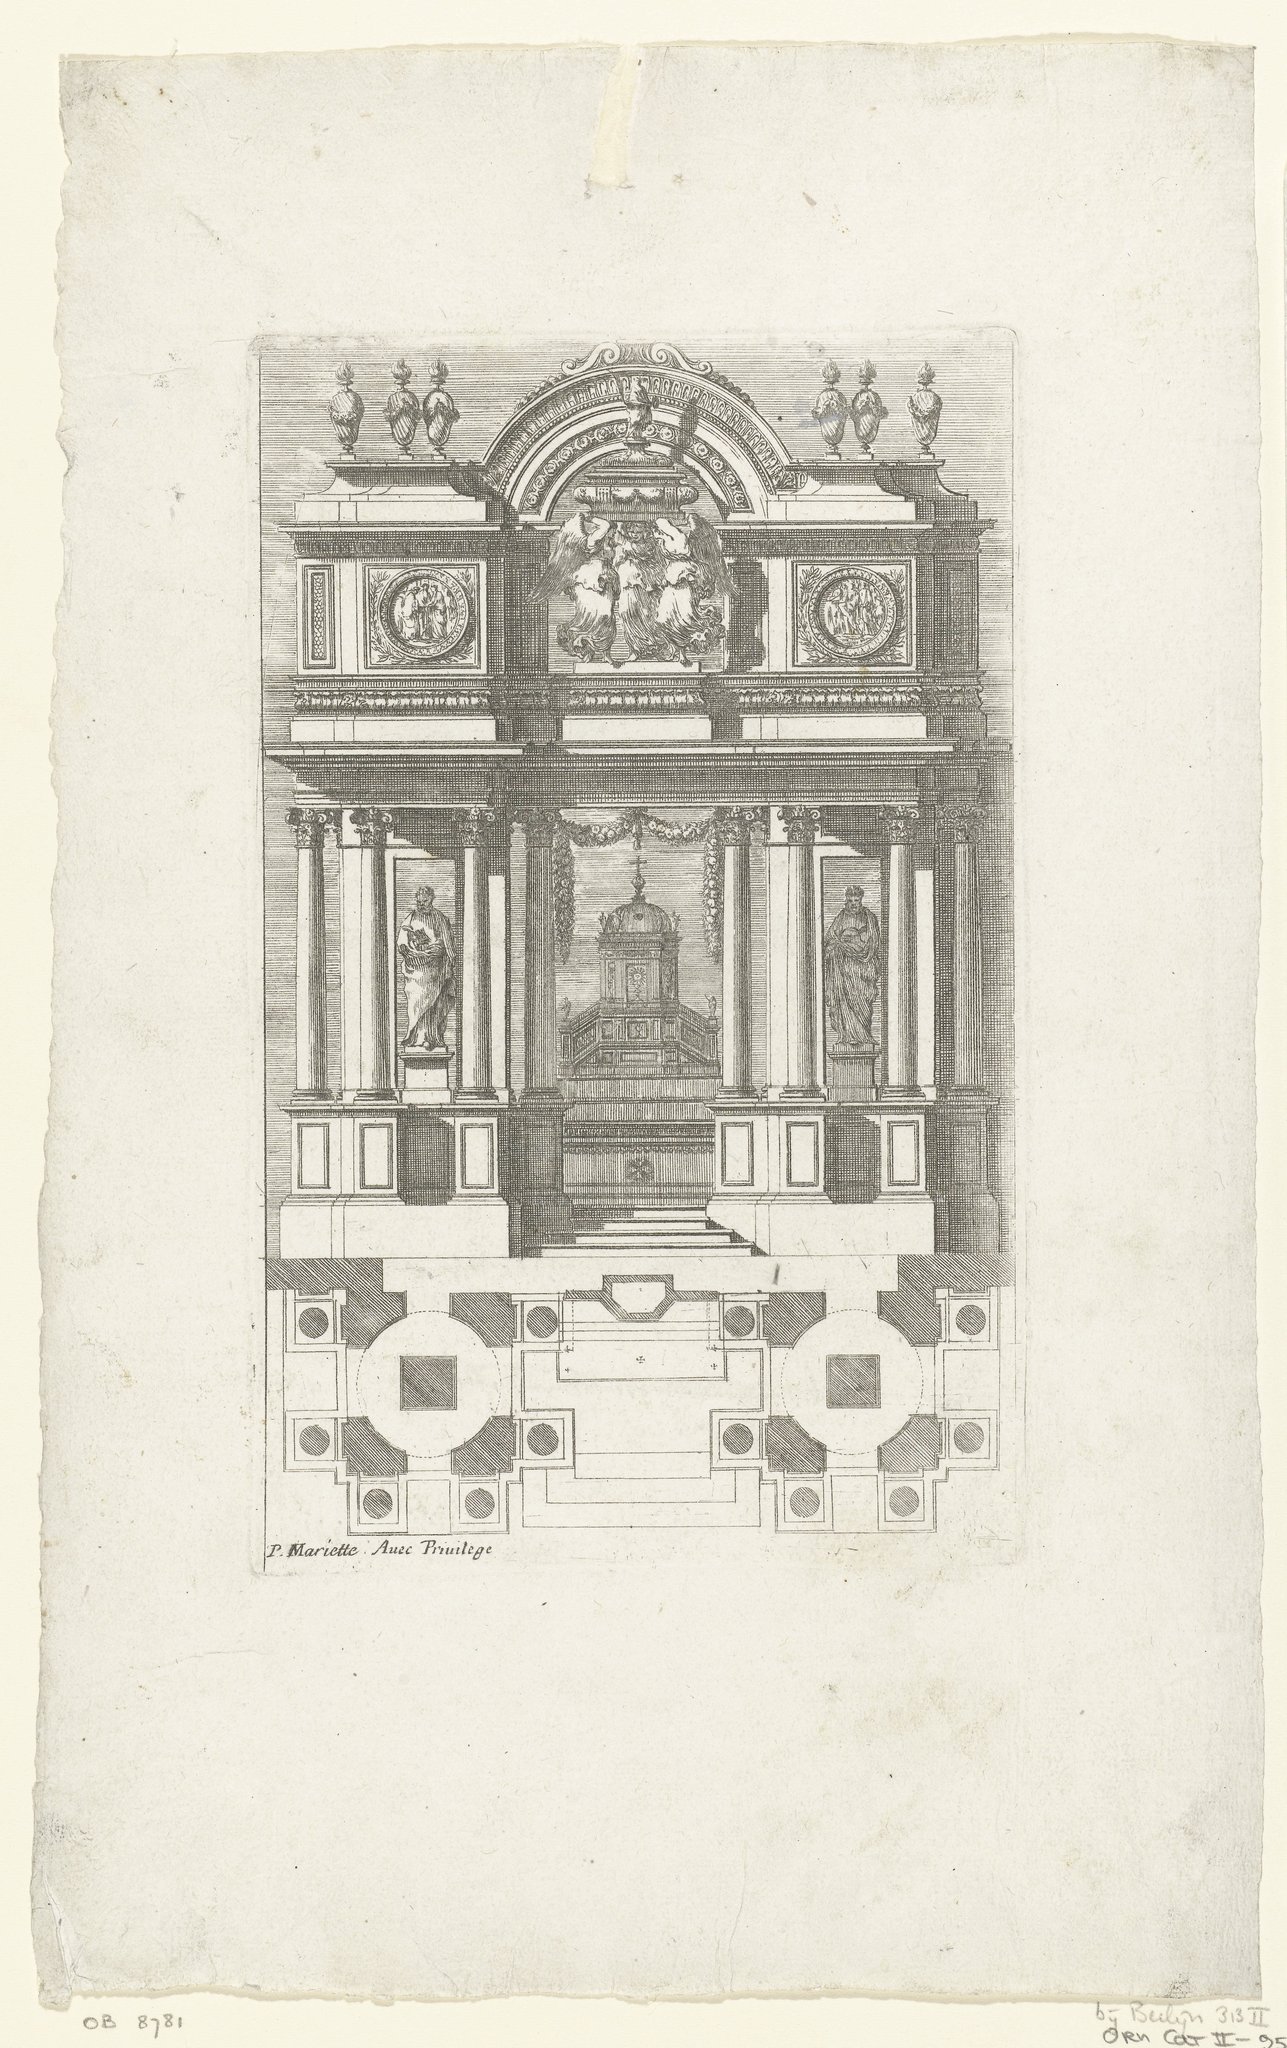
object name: ornament print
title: Altaar in de vorm van triomfboog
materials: paper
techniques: etching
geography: france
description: Op het hoofdgestel staat een attiek. Met opstand en plan. Uit serie van 6 bladen, tweede editie.